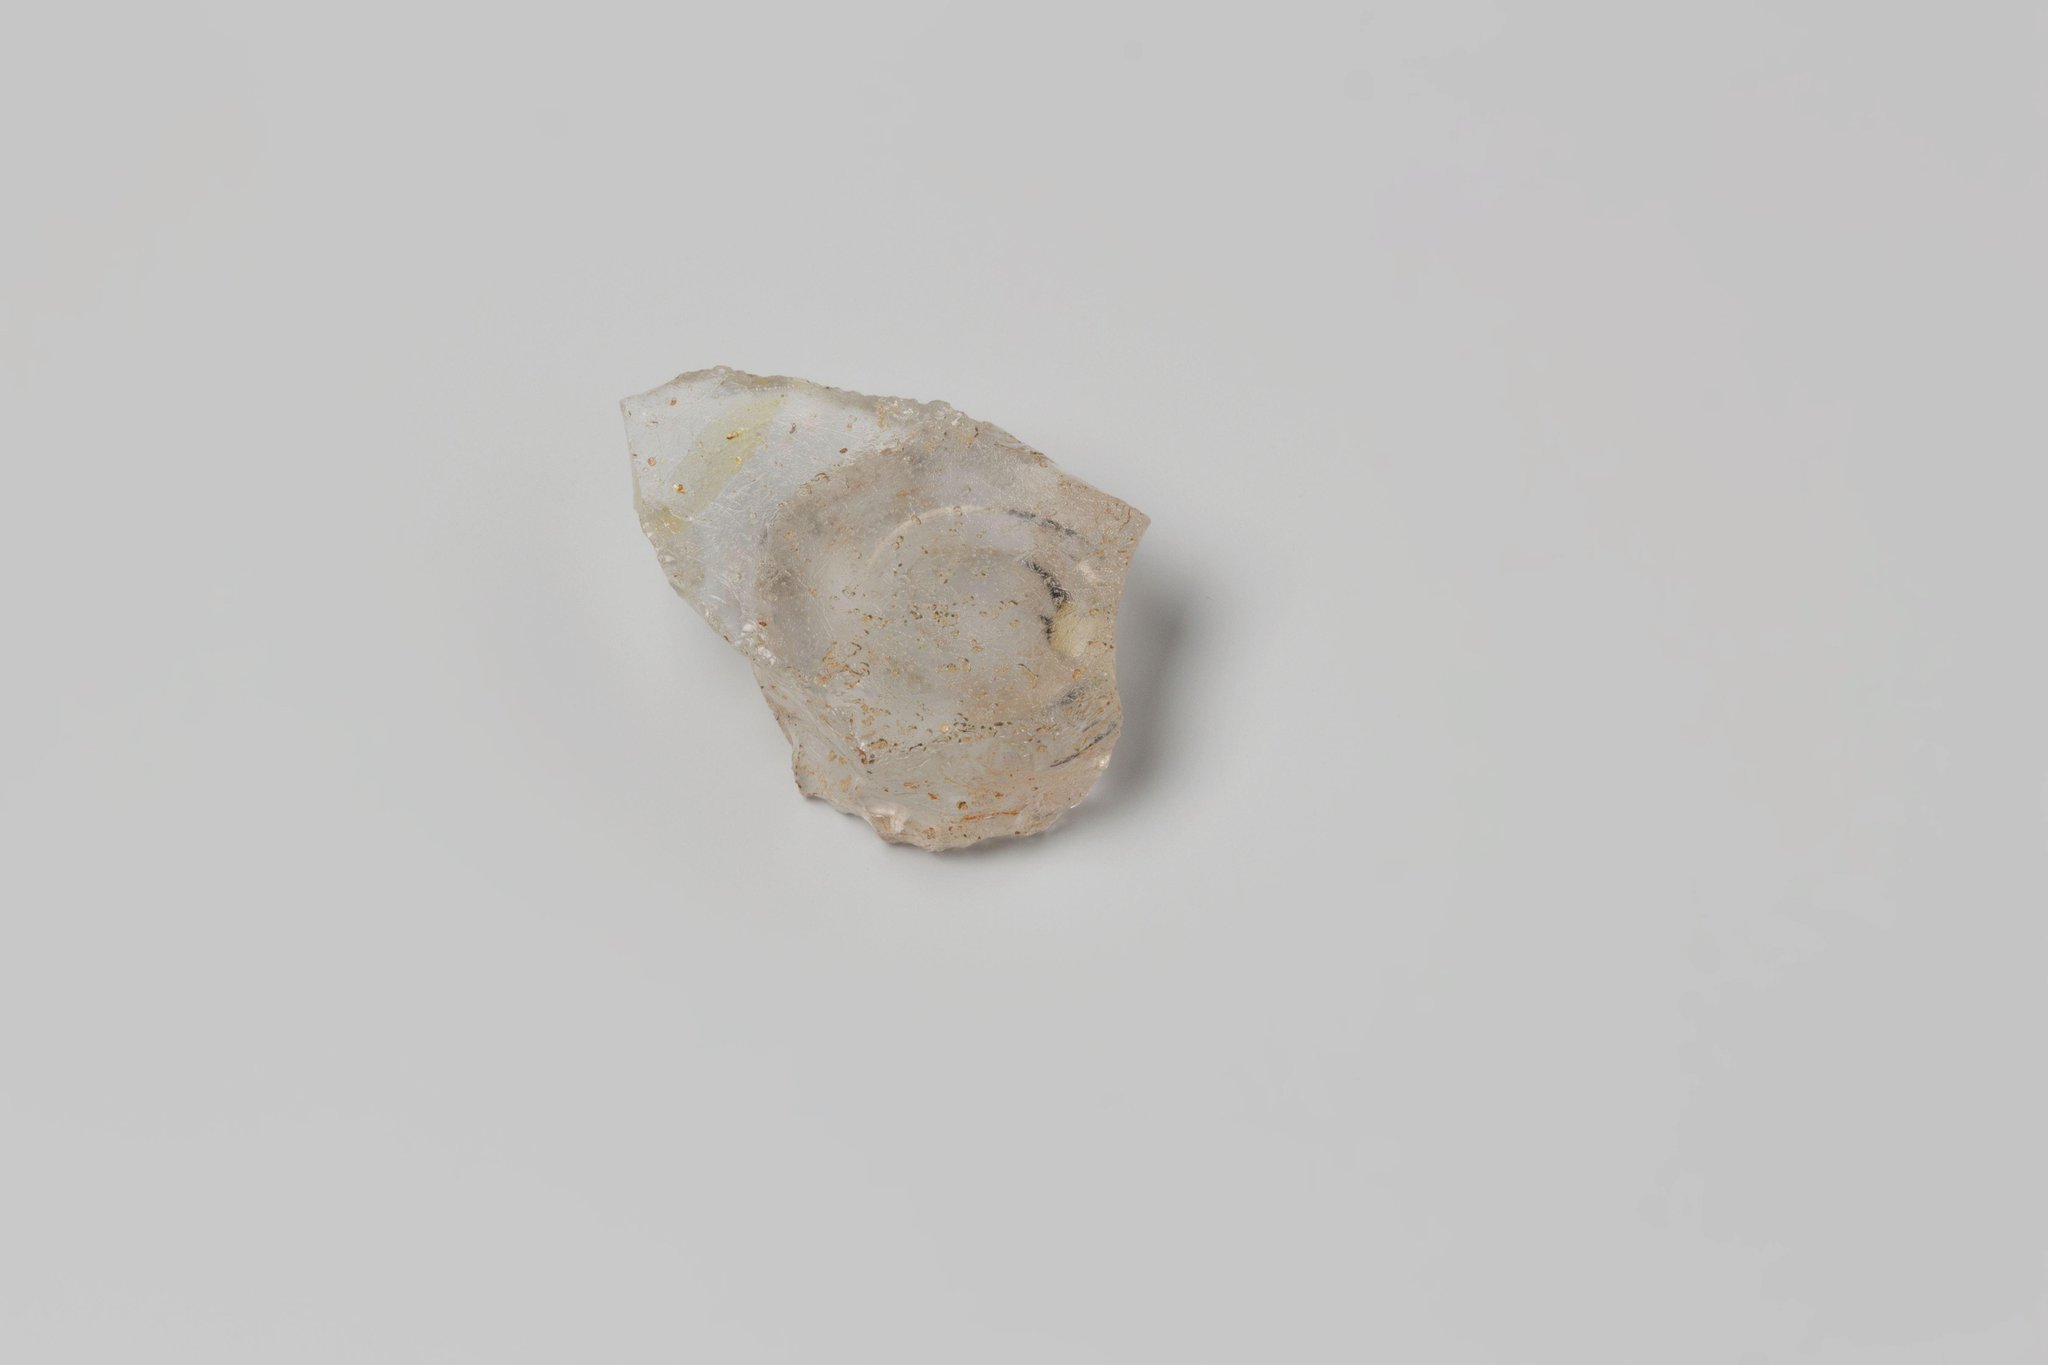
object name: foot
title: Fragment voet van vaatwerk uit het wrak van de Oost-Indiëvaarder Hollandia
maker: Anonymous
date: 1700-1743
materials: glass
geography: netherlands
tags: verenigde oostindische compagnie, hollandia (schip), annet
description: Vessel part, basal feet; fragm, circular, flat, foot extending beyond outline of base.